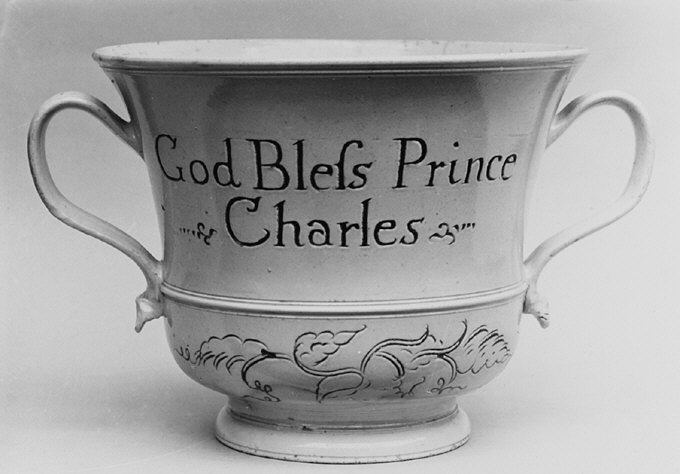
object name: loving cup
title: Jacobite loving cup with Charles Edward Stuart (1720–1788)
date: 1745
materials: stoneware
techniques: salt glaze